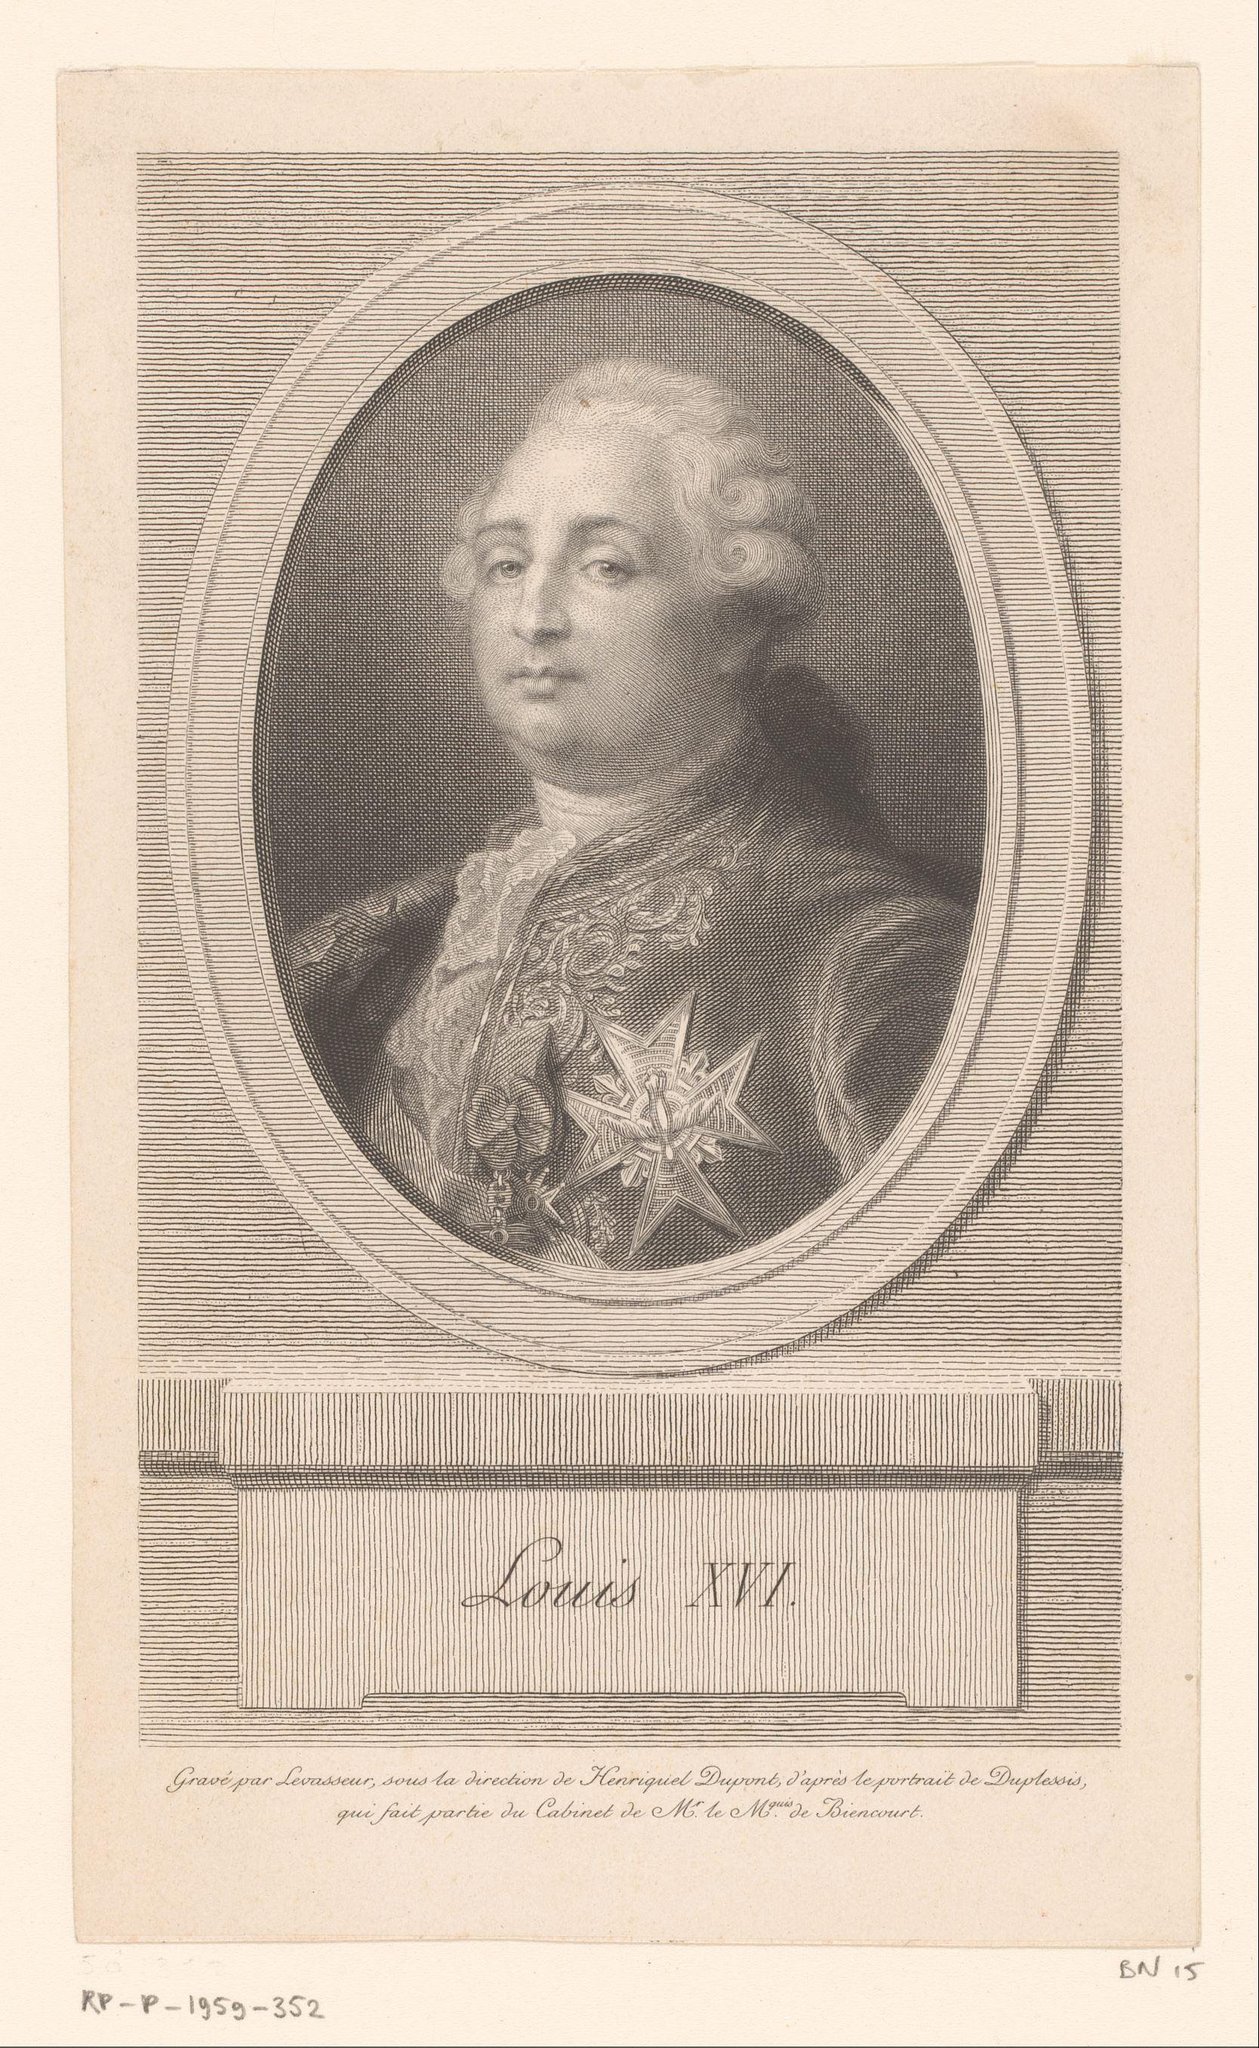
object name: print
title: Louis XVI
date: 1861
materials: paper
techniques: engraving, etching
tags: paris, lodewijk xvi (koning van frankrijk), historical persons, king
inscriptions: collector's mark: Lugt 2228, collector's mark: Lugt 2760, collector's mark: Lugt 4347